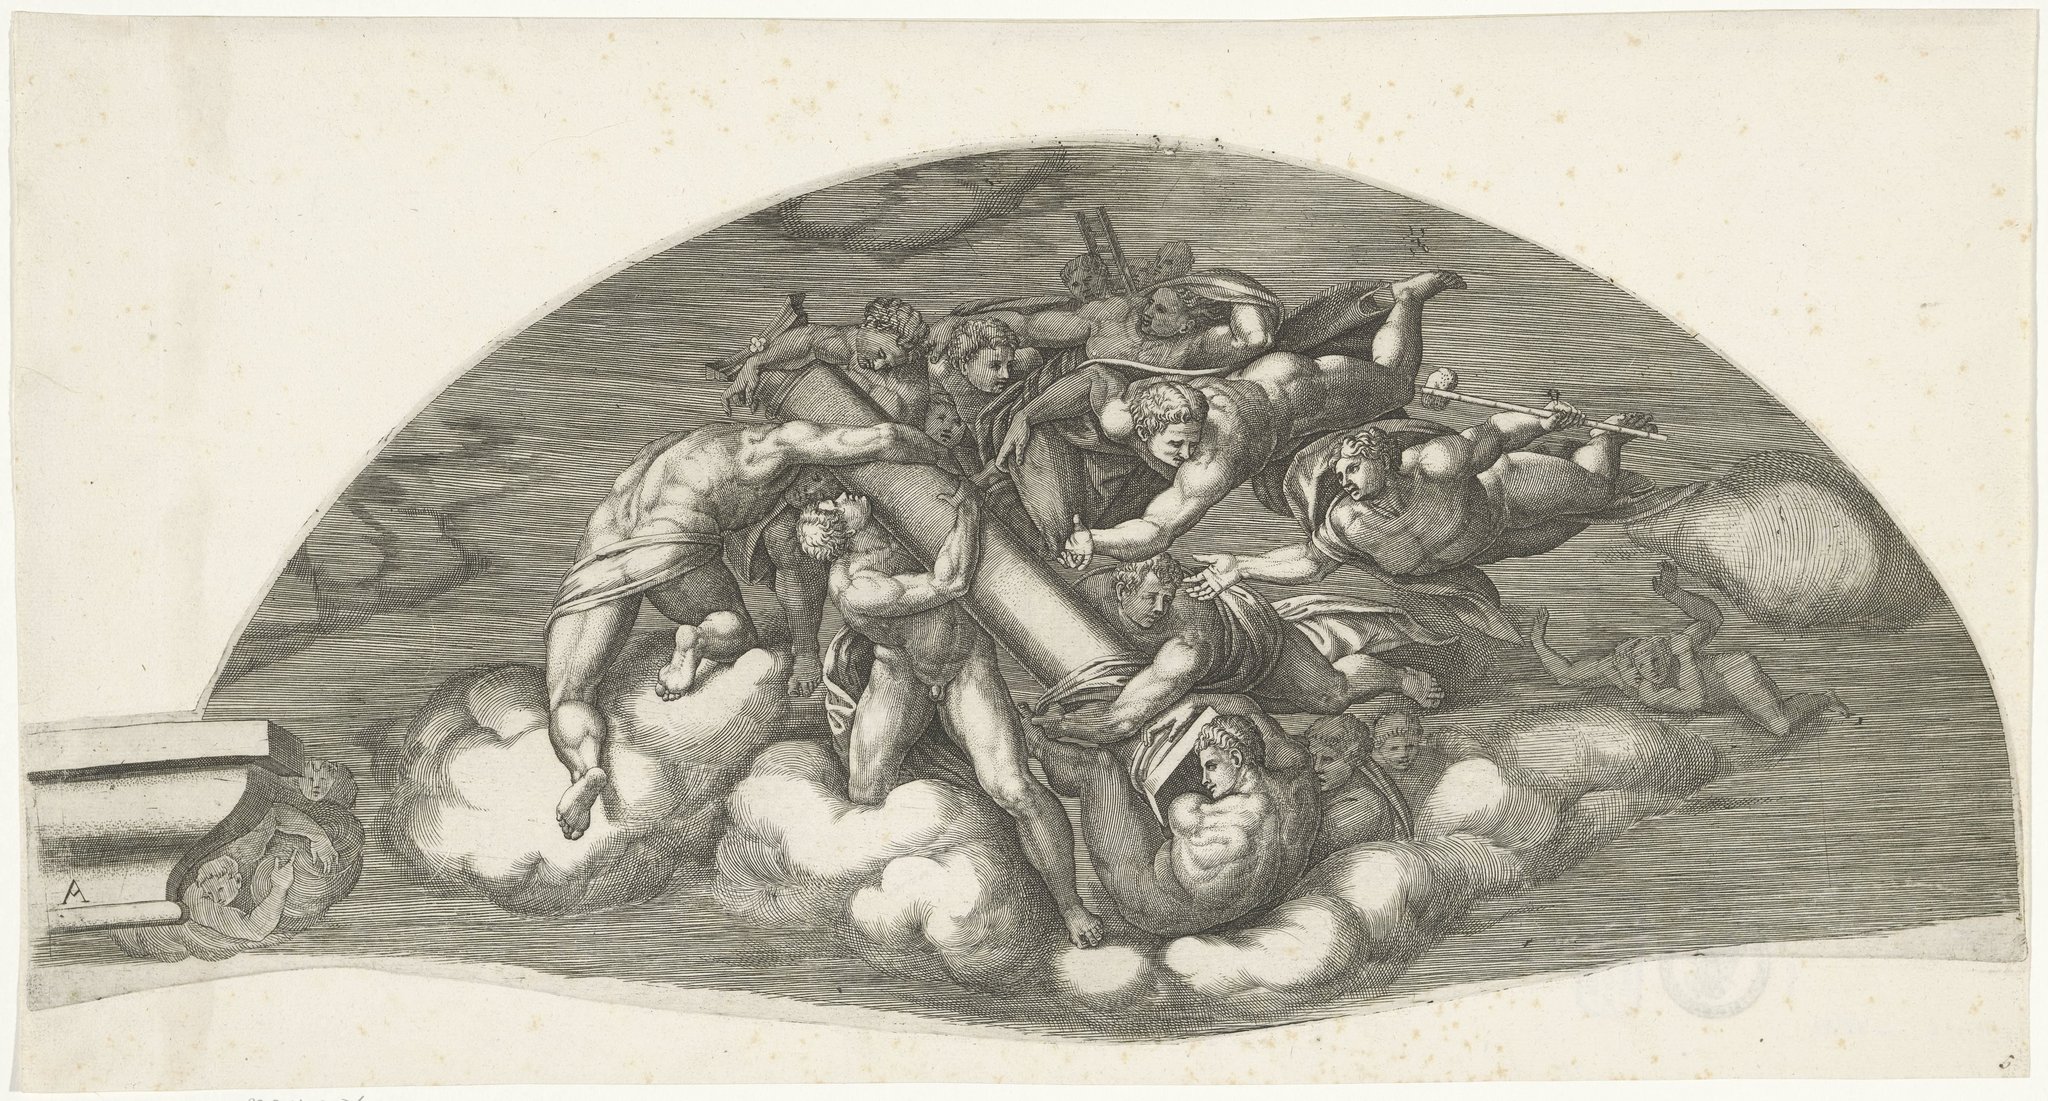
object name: print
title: Het laatste oordeel, blad A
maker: giorgio ghisi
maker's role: print maker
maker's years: 1520-1582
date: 1530-1582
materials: paper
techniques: engraving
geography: vatican city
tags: last judgement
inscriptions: collector's mark: Lugt 10, collector's mark: Lugt 11, collector's mark: ‘Hinloopen’, number: ‘5’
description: Prent maakt deel uit van een groep van tien prenten die samen één grote voorstelling vormen naar het fresco met het Laatste Oordeel door Michelangelo in de Sixtijnse Kapel in het Vaticaan.